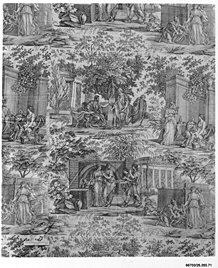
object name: furnishing textile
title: Achilles recognized by Ulysses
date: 1825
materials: cotton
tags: human figures,trees